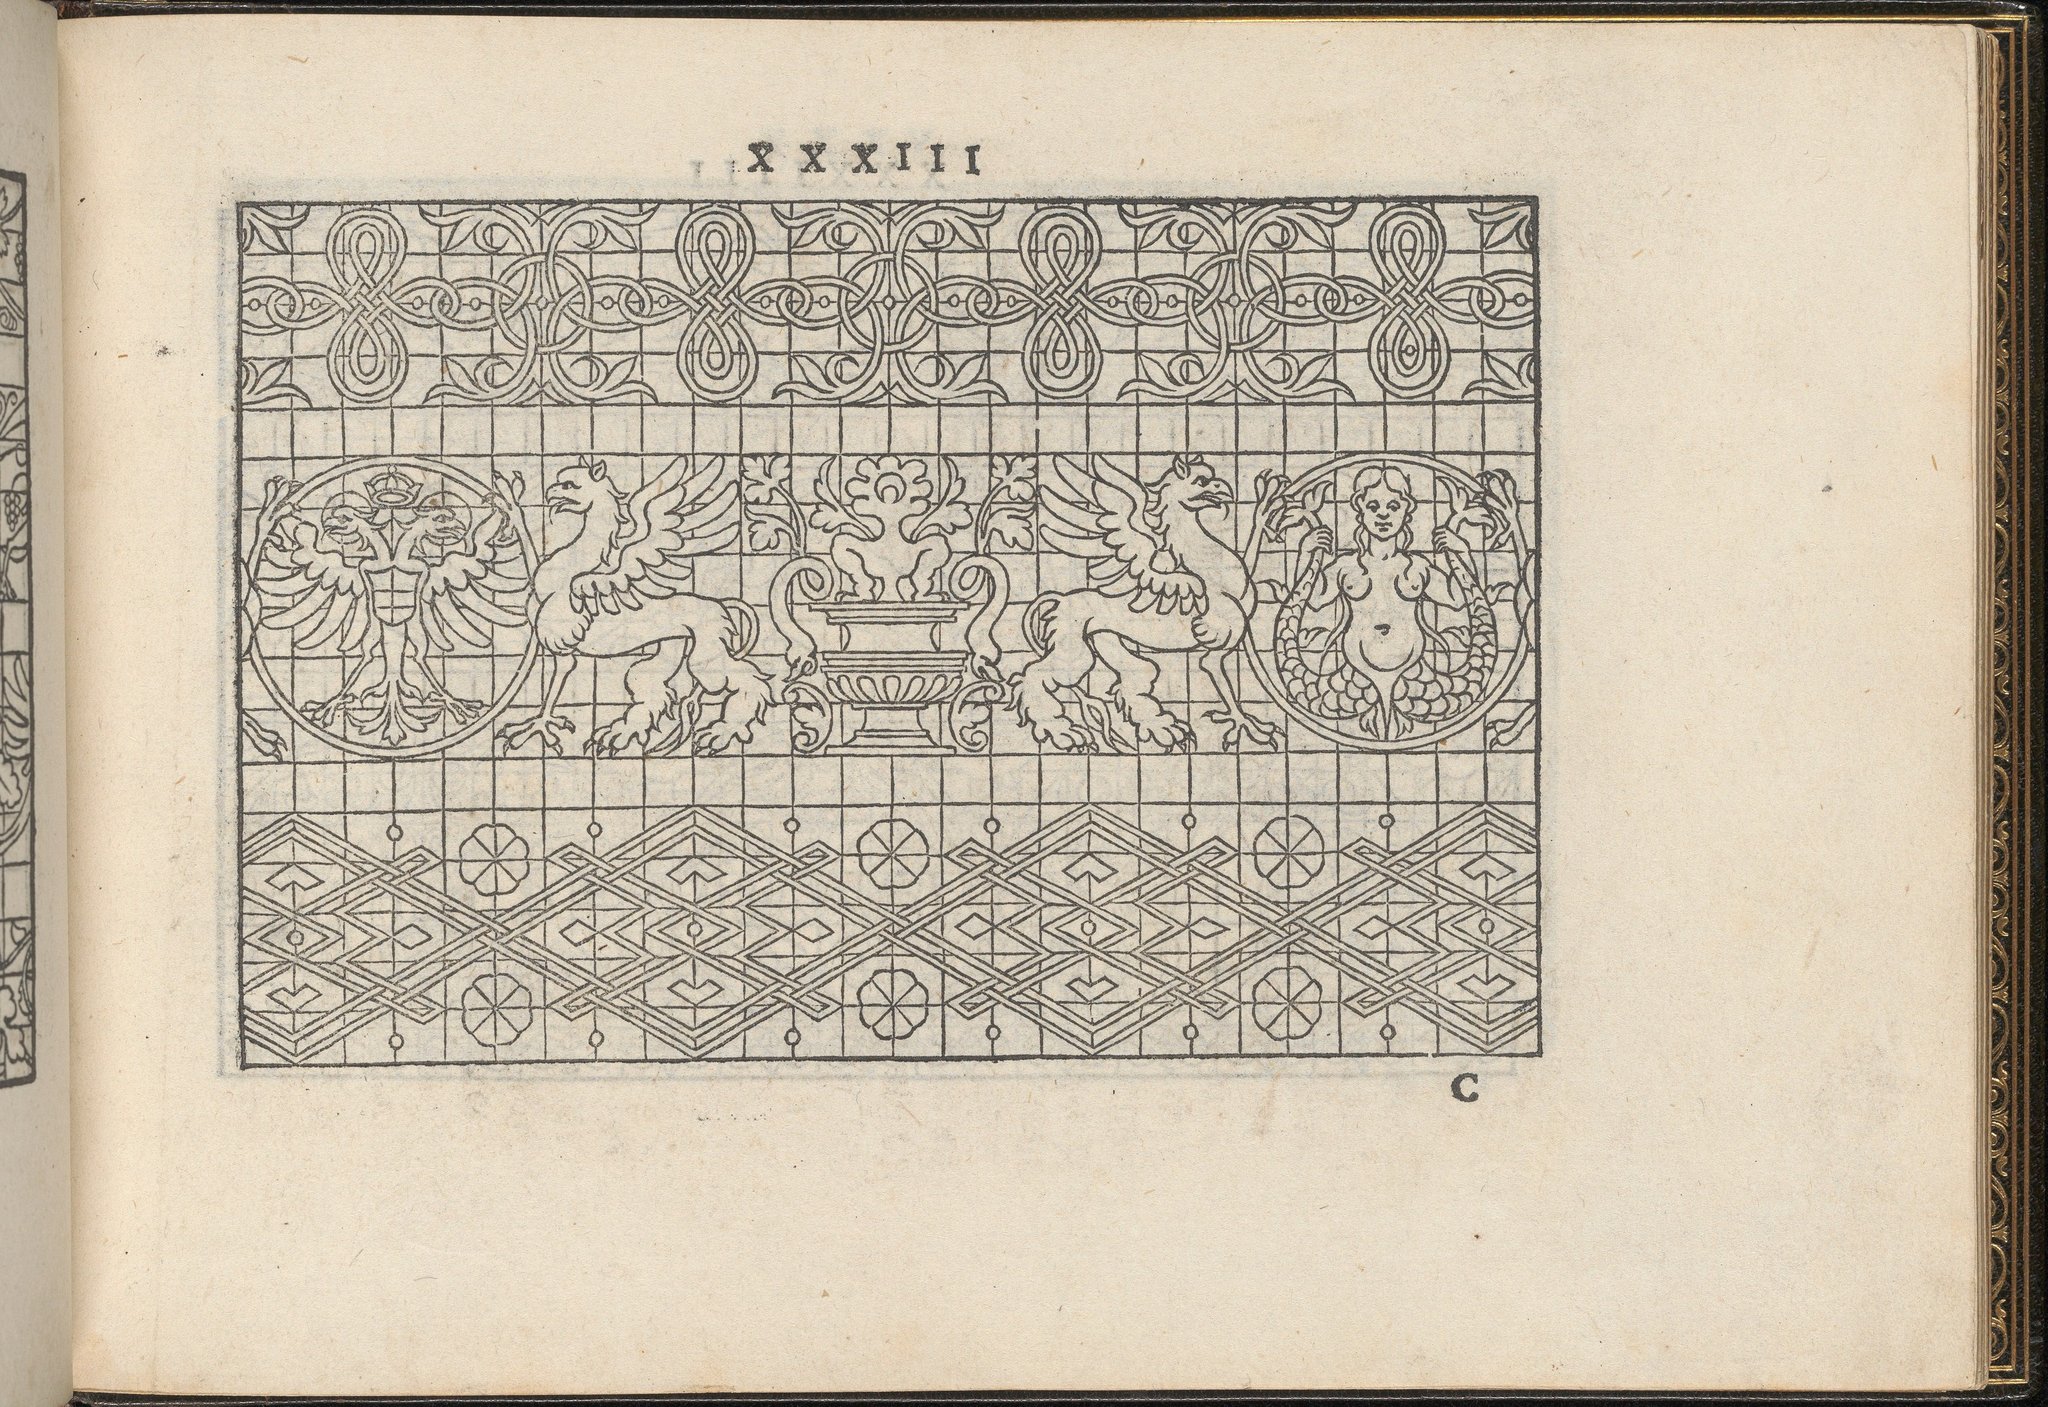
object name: book print ornament architecture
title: La Vera Perfettione del Disegno di varie sorti di recami, page 17 (recto)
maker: giovanni ostaus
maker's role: publisher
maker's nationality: italian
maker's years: 1507-1607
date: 1567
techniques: woodcut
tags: birds,griffins,flowers